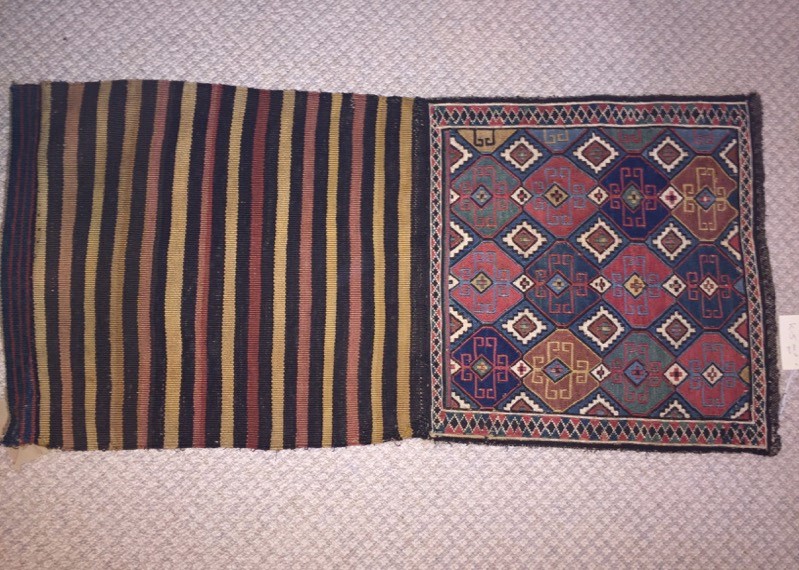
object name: saddle bag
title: Shahsevan Double Saddle Bag (Pair)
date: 1870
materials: cotton, wool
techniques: brocade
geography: iran